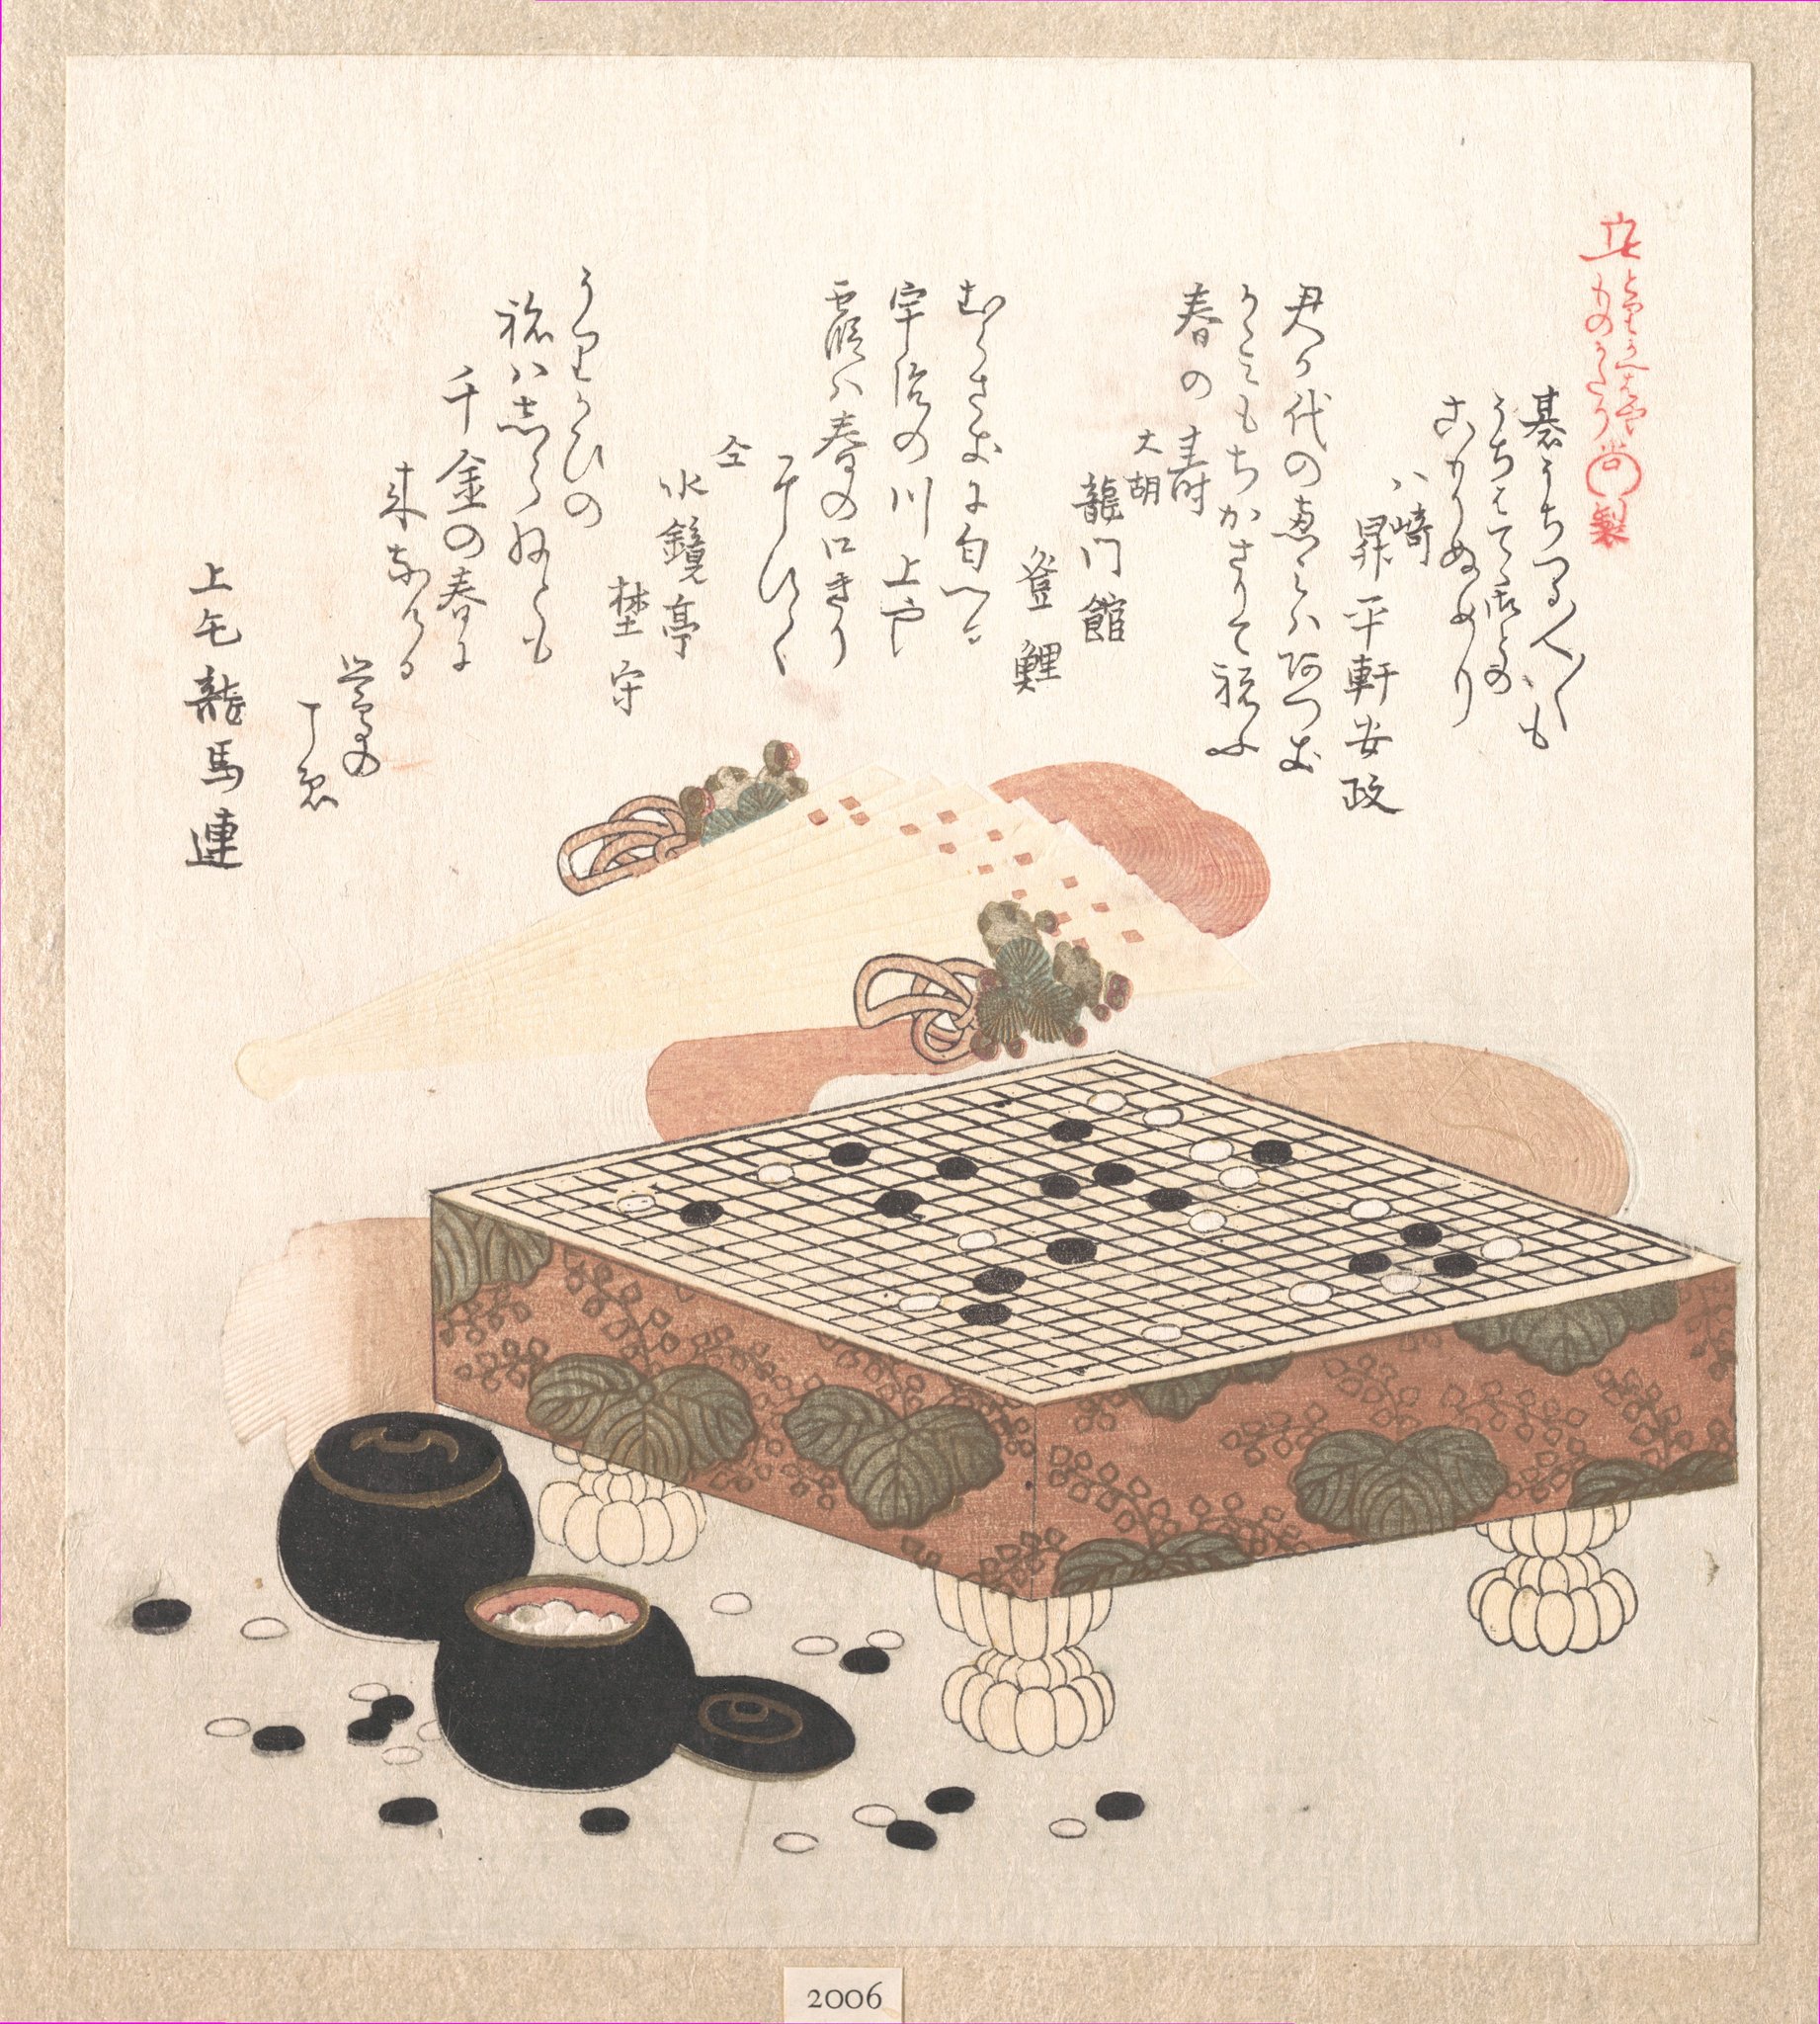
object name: print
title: Outfit for the Go Game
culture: japanese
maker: kubo shunman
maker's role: artist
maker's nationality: japanese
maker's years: 1757-1820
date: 1801-1900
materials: ink, paper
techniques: surimono, woodblock print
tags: games